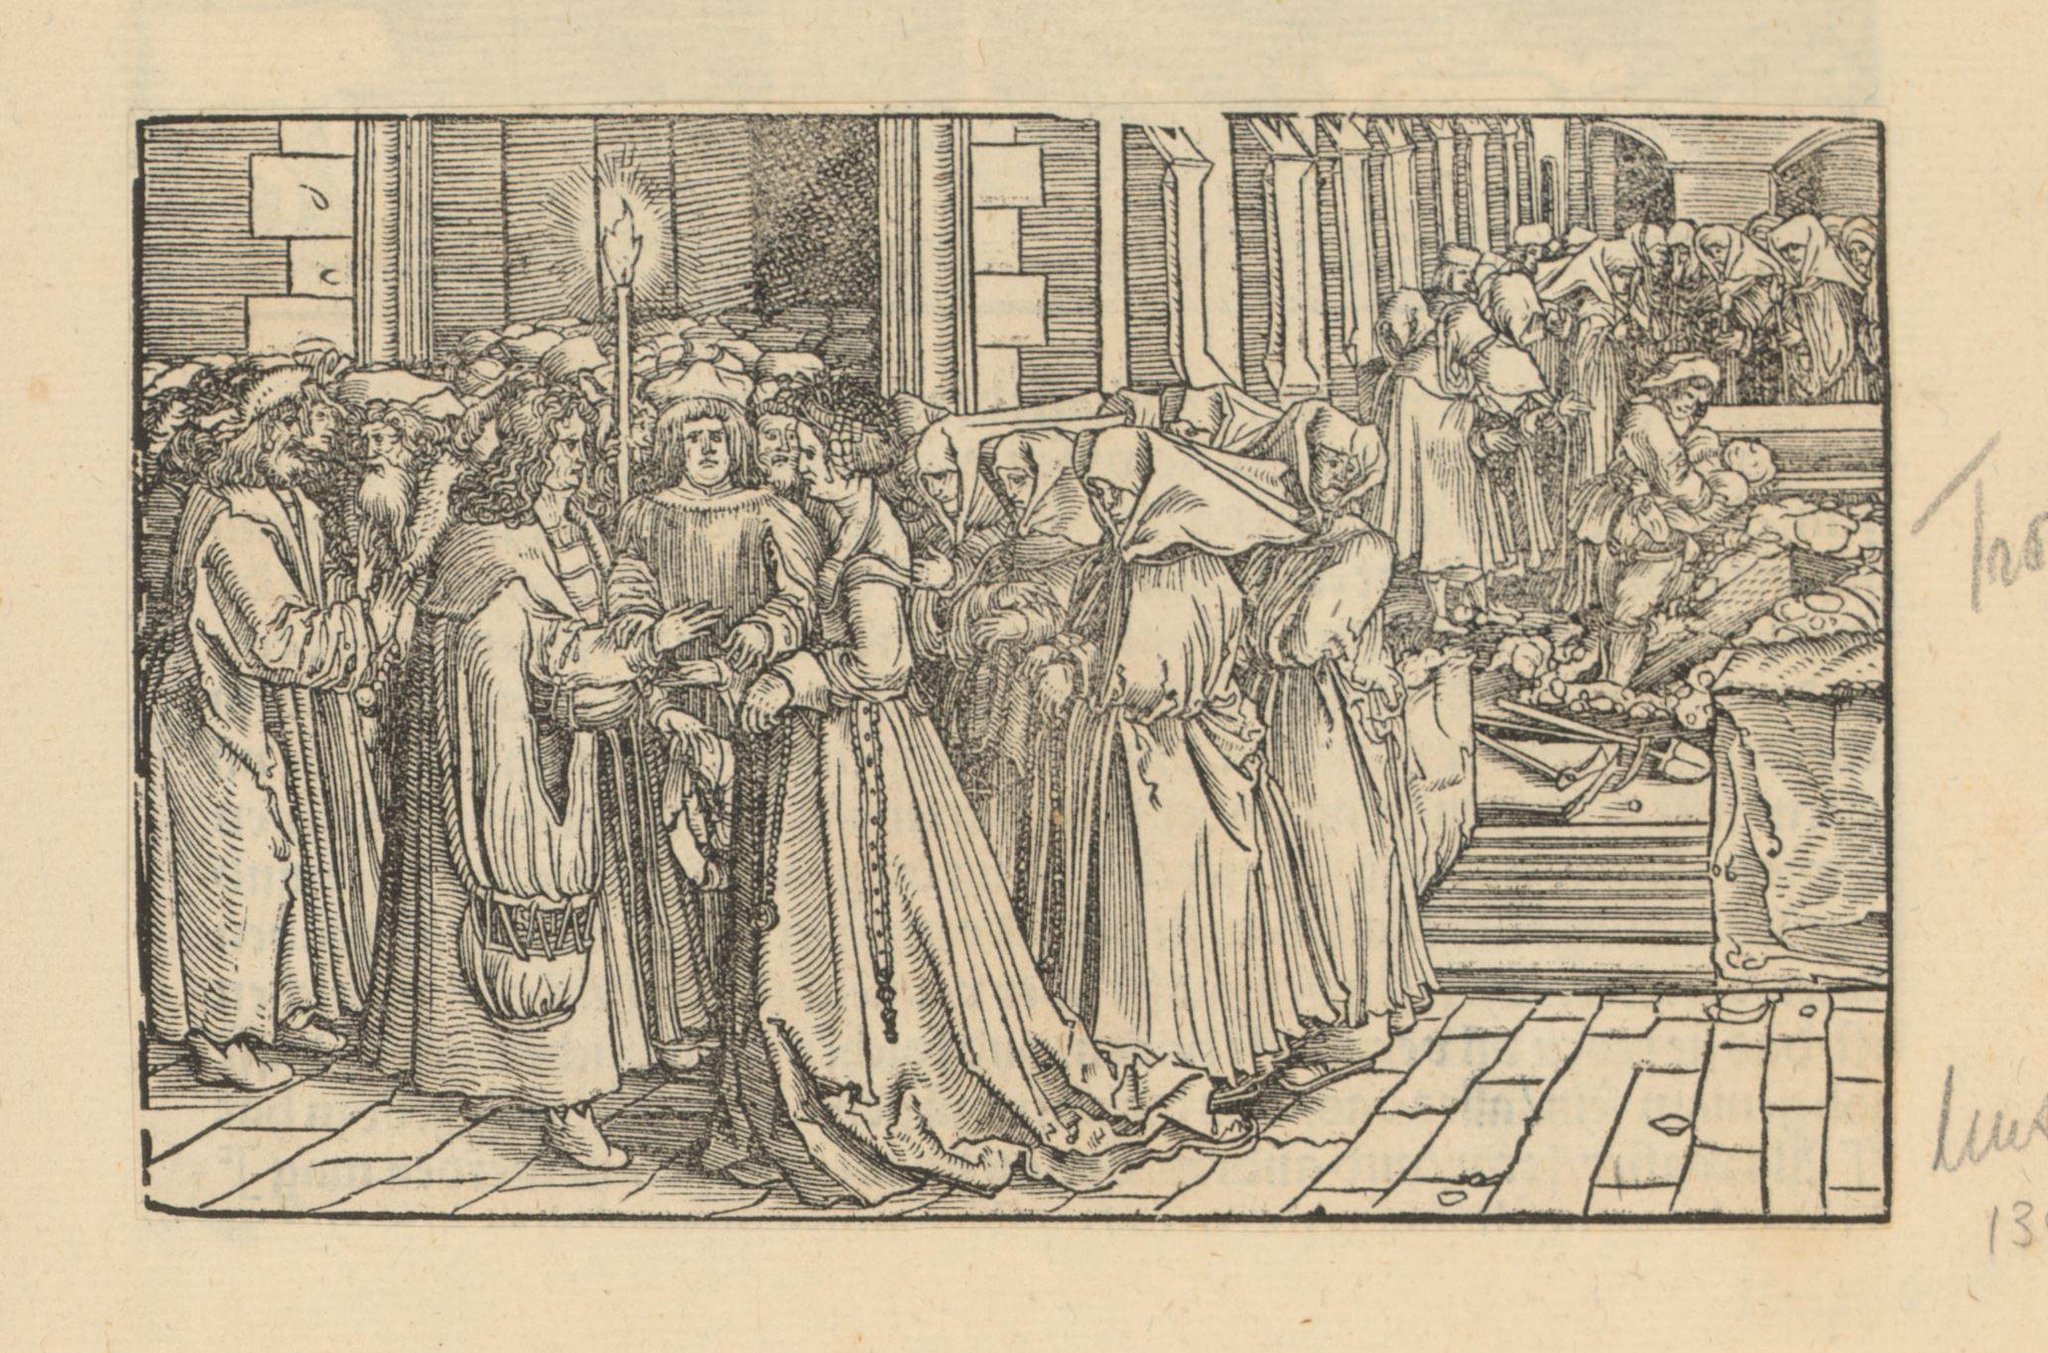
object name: album leaf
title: Huwelijk van een man en zijn tweede vrouw terwijl zijn eerste vrouw wordt begraven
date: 1514-1532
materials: paper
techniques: letterpress printing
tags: second marriage (of widow or widower), marriage, married couple, 'matrimonium'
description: Deze prent is gebruikt in: Petrarca, Francesco. Von der Artzney bayder Glück, des guten und widerwertigen: unnd weß sich ain yeder inn Gelück und Unglück halten sol (...). Augsburg: Heinrich Steiner, 1532. Deze uitgave is ook bekend onder de titel 'Trostspiegel in Glück und Unglück'. Deze prent is ook gebruikt in: Cicero, Marcus Tulius. Officia M.T.C. Ein Buch so Marcus Tullius Cicero der Römer zu seynem (...). [Vertaald uit het Latijn door] Johann von Schwarzenberg. Augsburg: Heinrich Steiner, 1531.